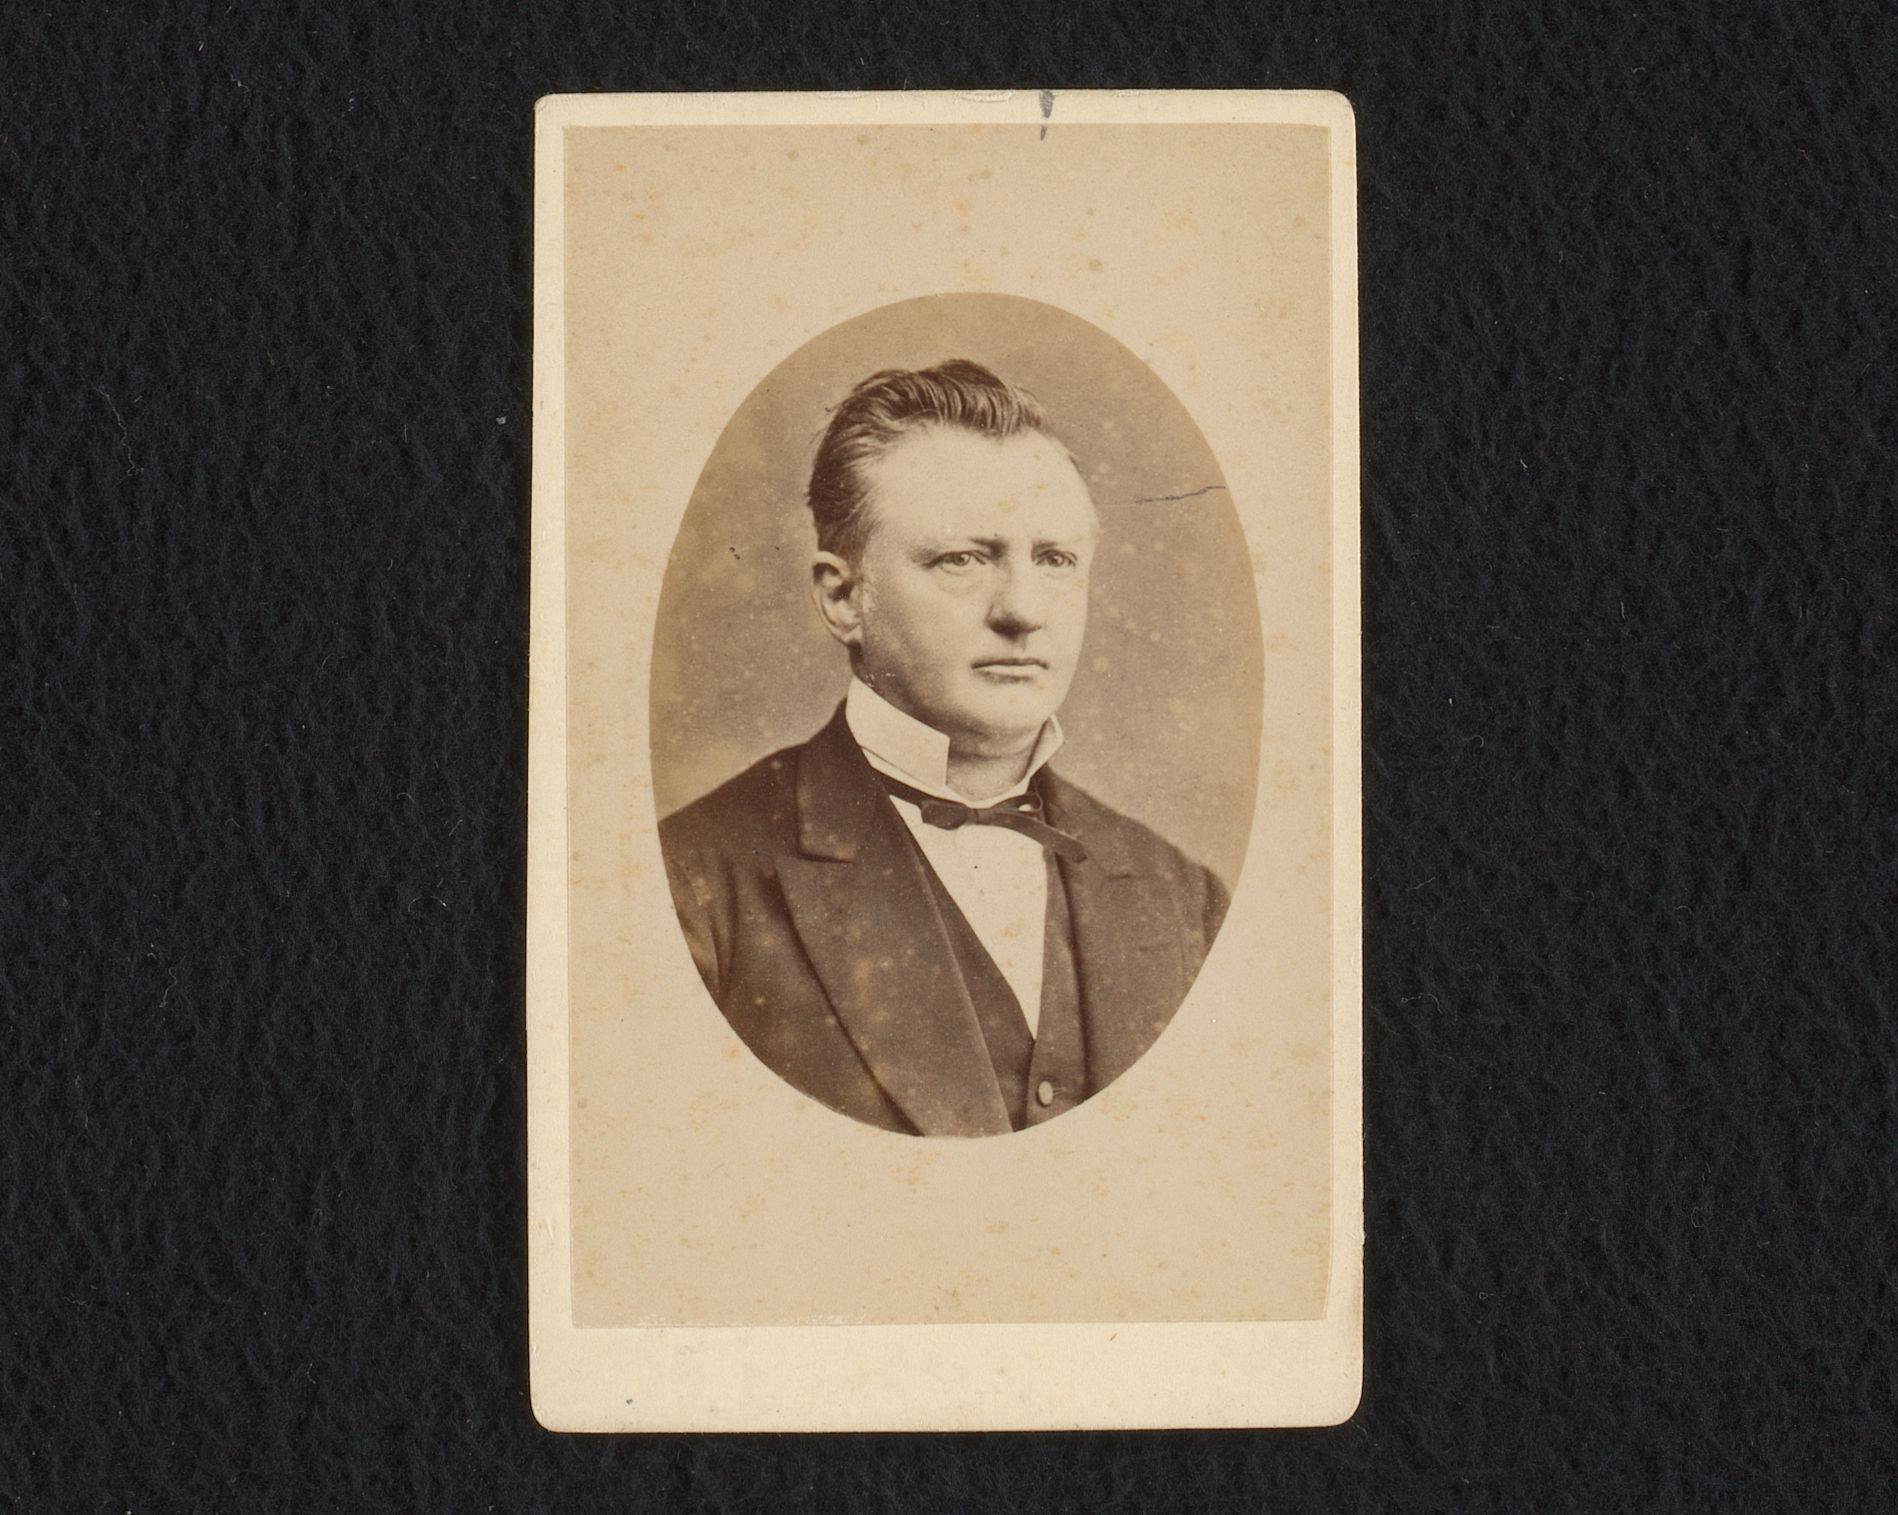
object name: carte de visite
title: Portret van Geldolph de Lange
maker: pieter vlaanderen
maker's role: fotograaf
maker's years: 1840-1878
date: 1867-1874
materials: cardboard, paper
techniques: albumen print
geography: alkmaar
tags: the hague, historical persons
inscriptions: address: ‘Verdronken Oord/ Wyk D. No 34./ ALKMAAR.’